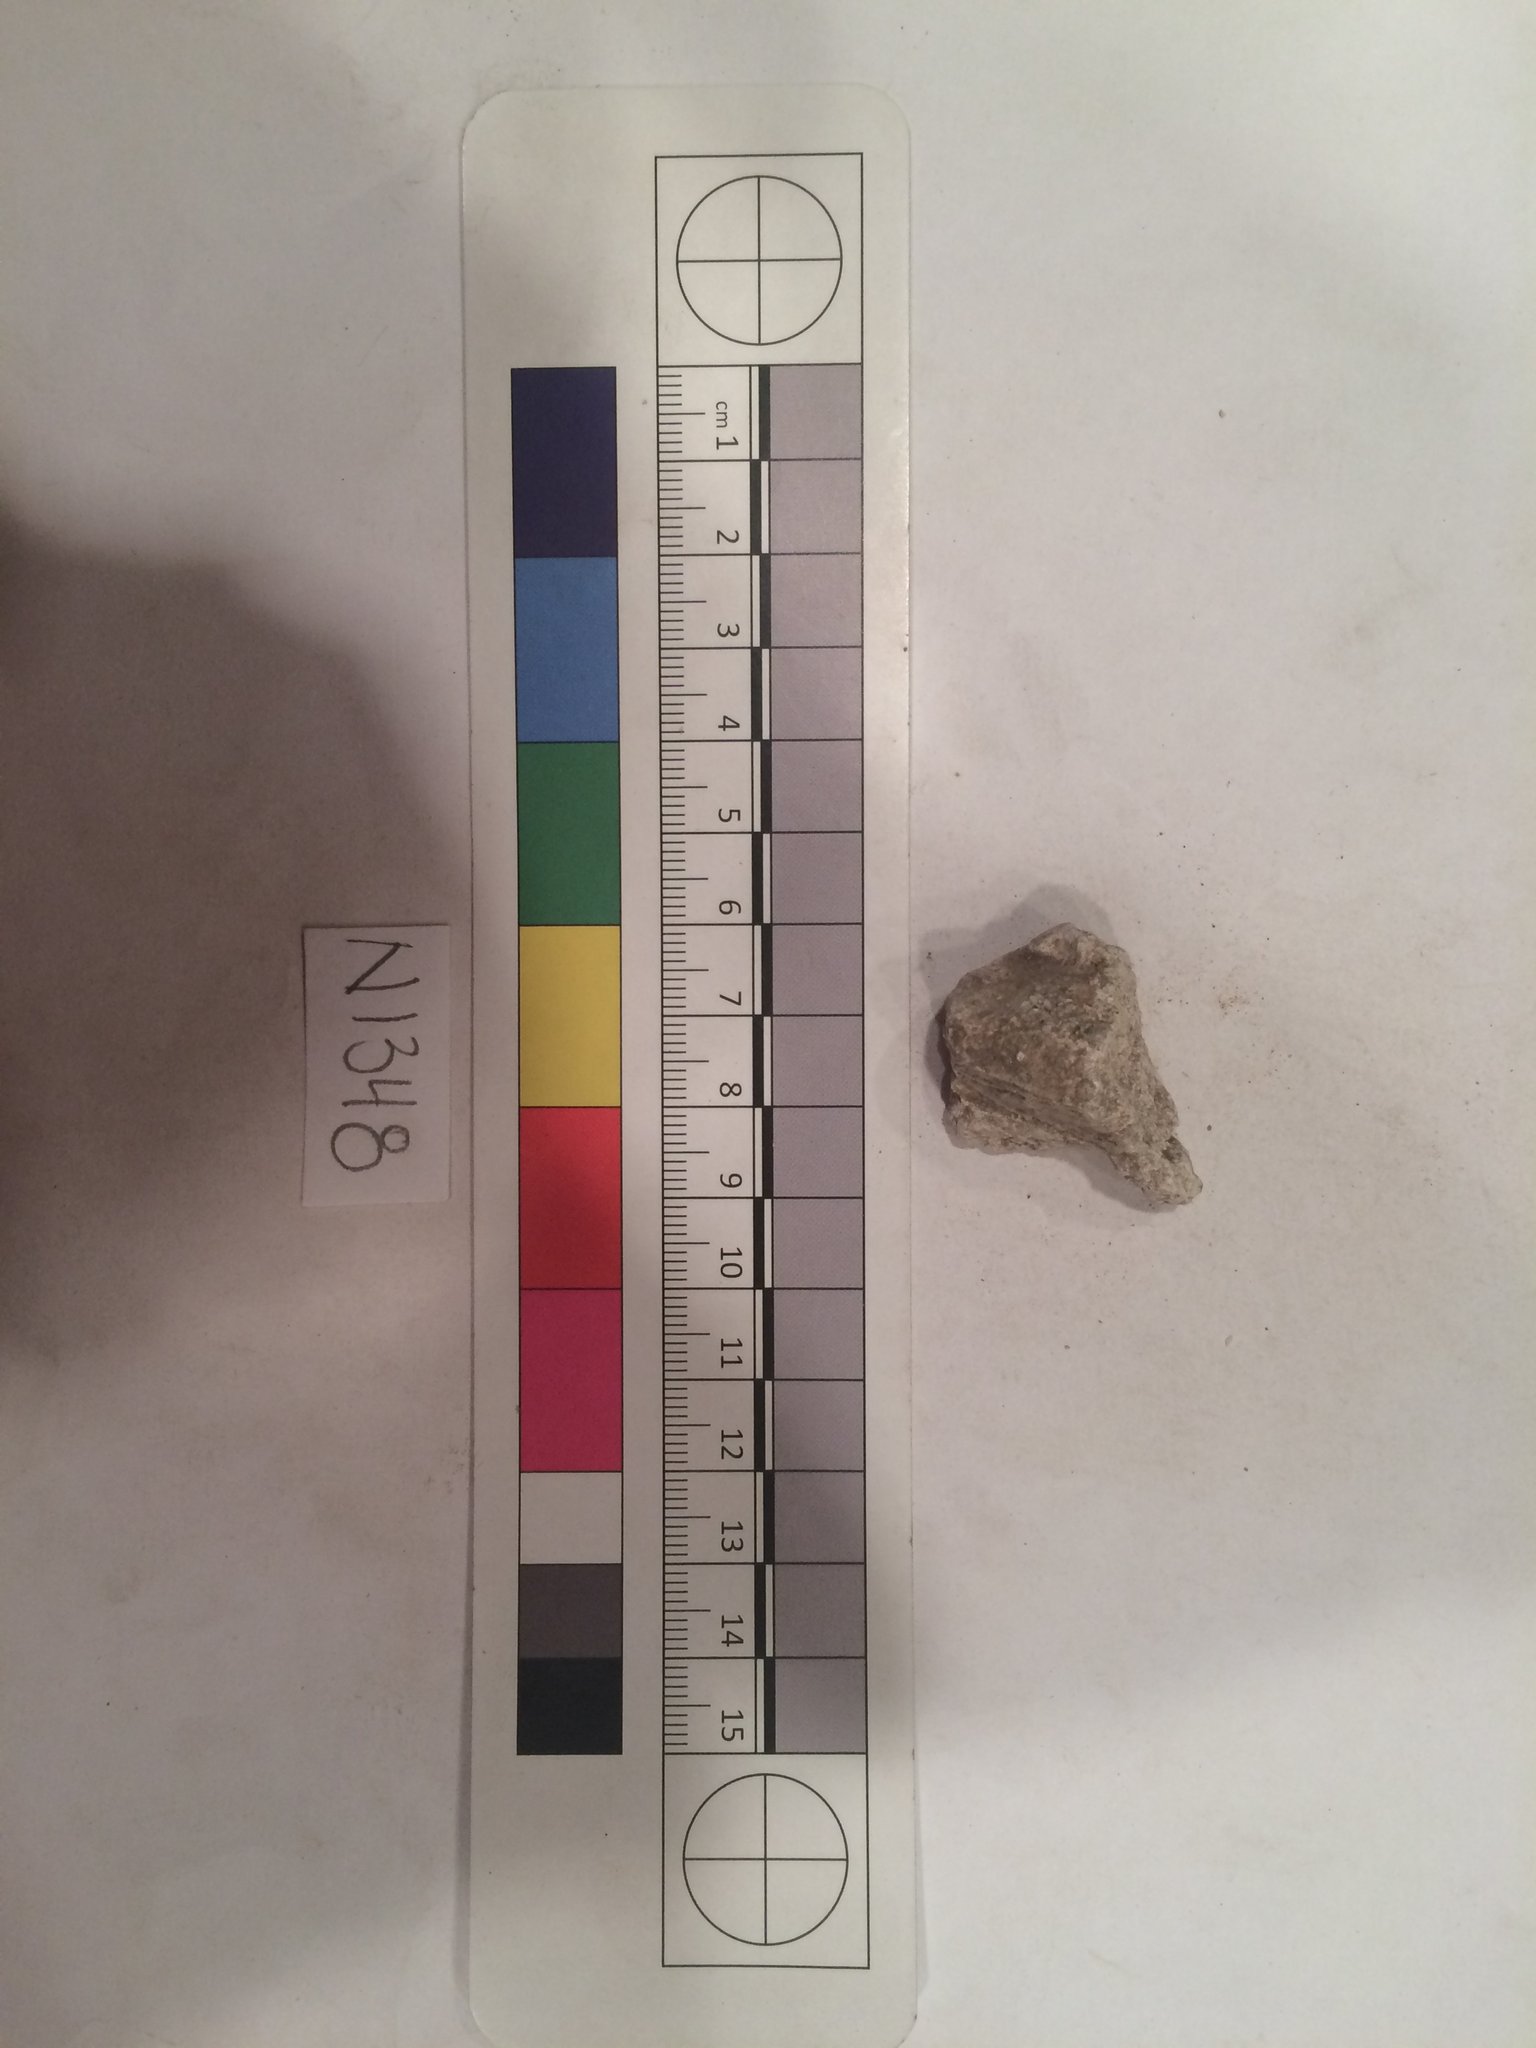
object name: fragment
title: Stucco Fragment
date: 701-1200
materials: plaster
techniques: carving, painting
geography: iran